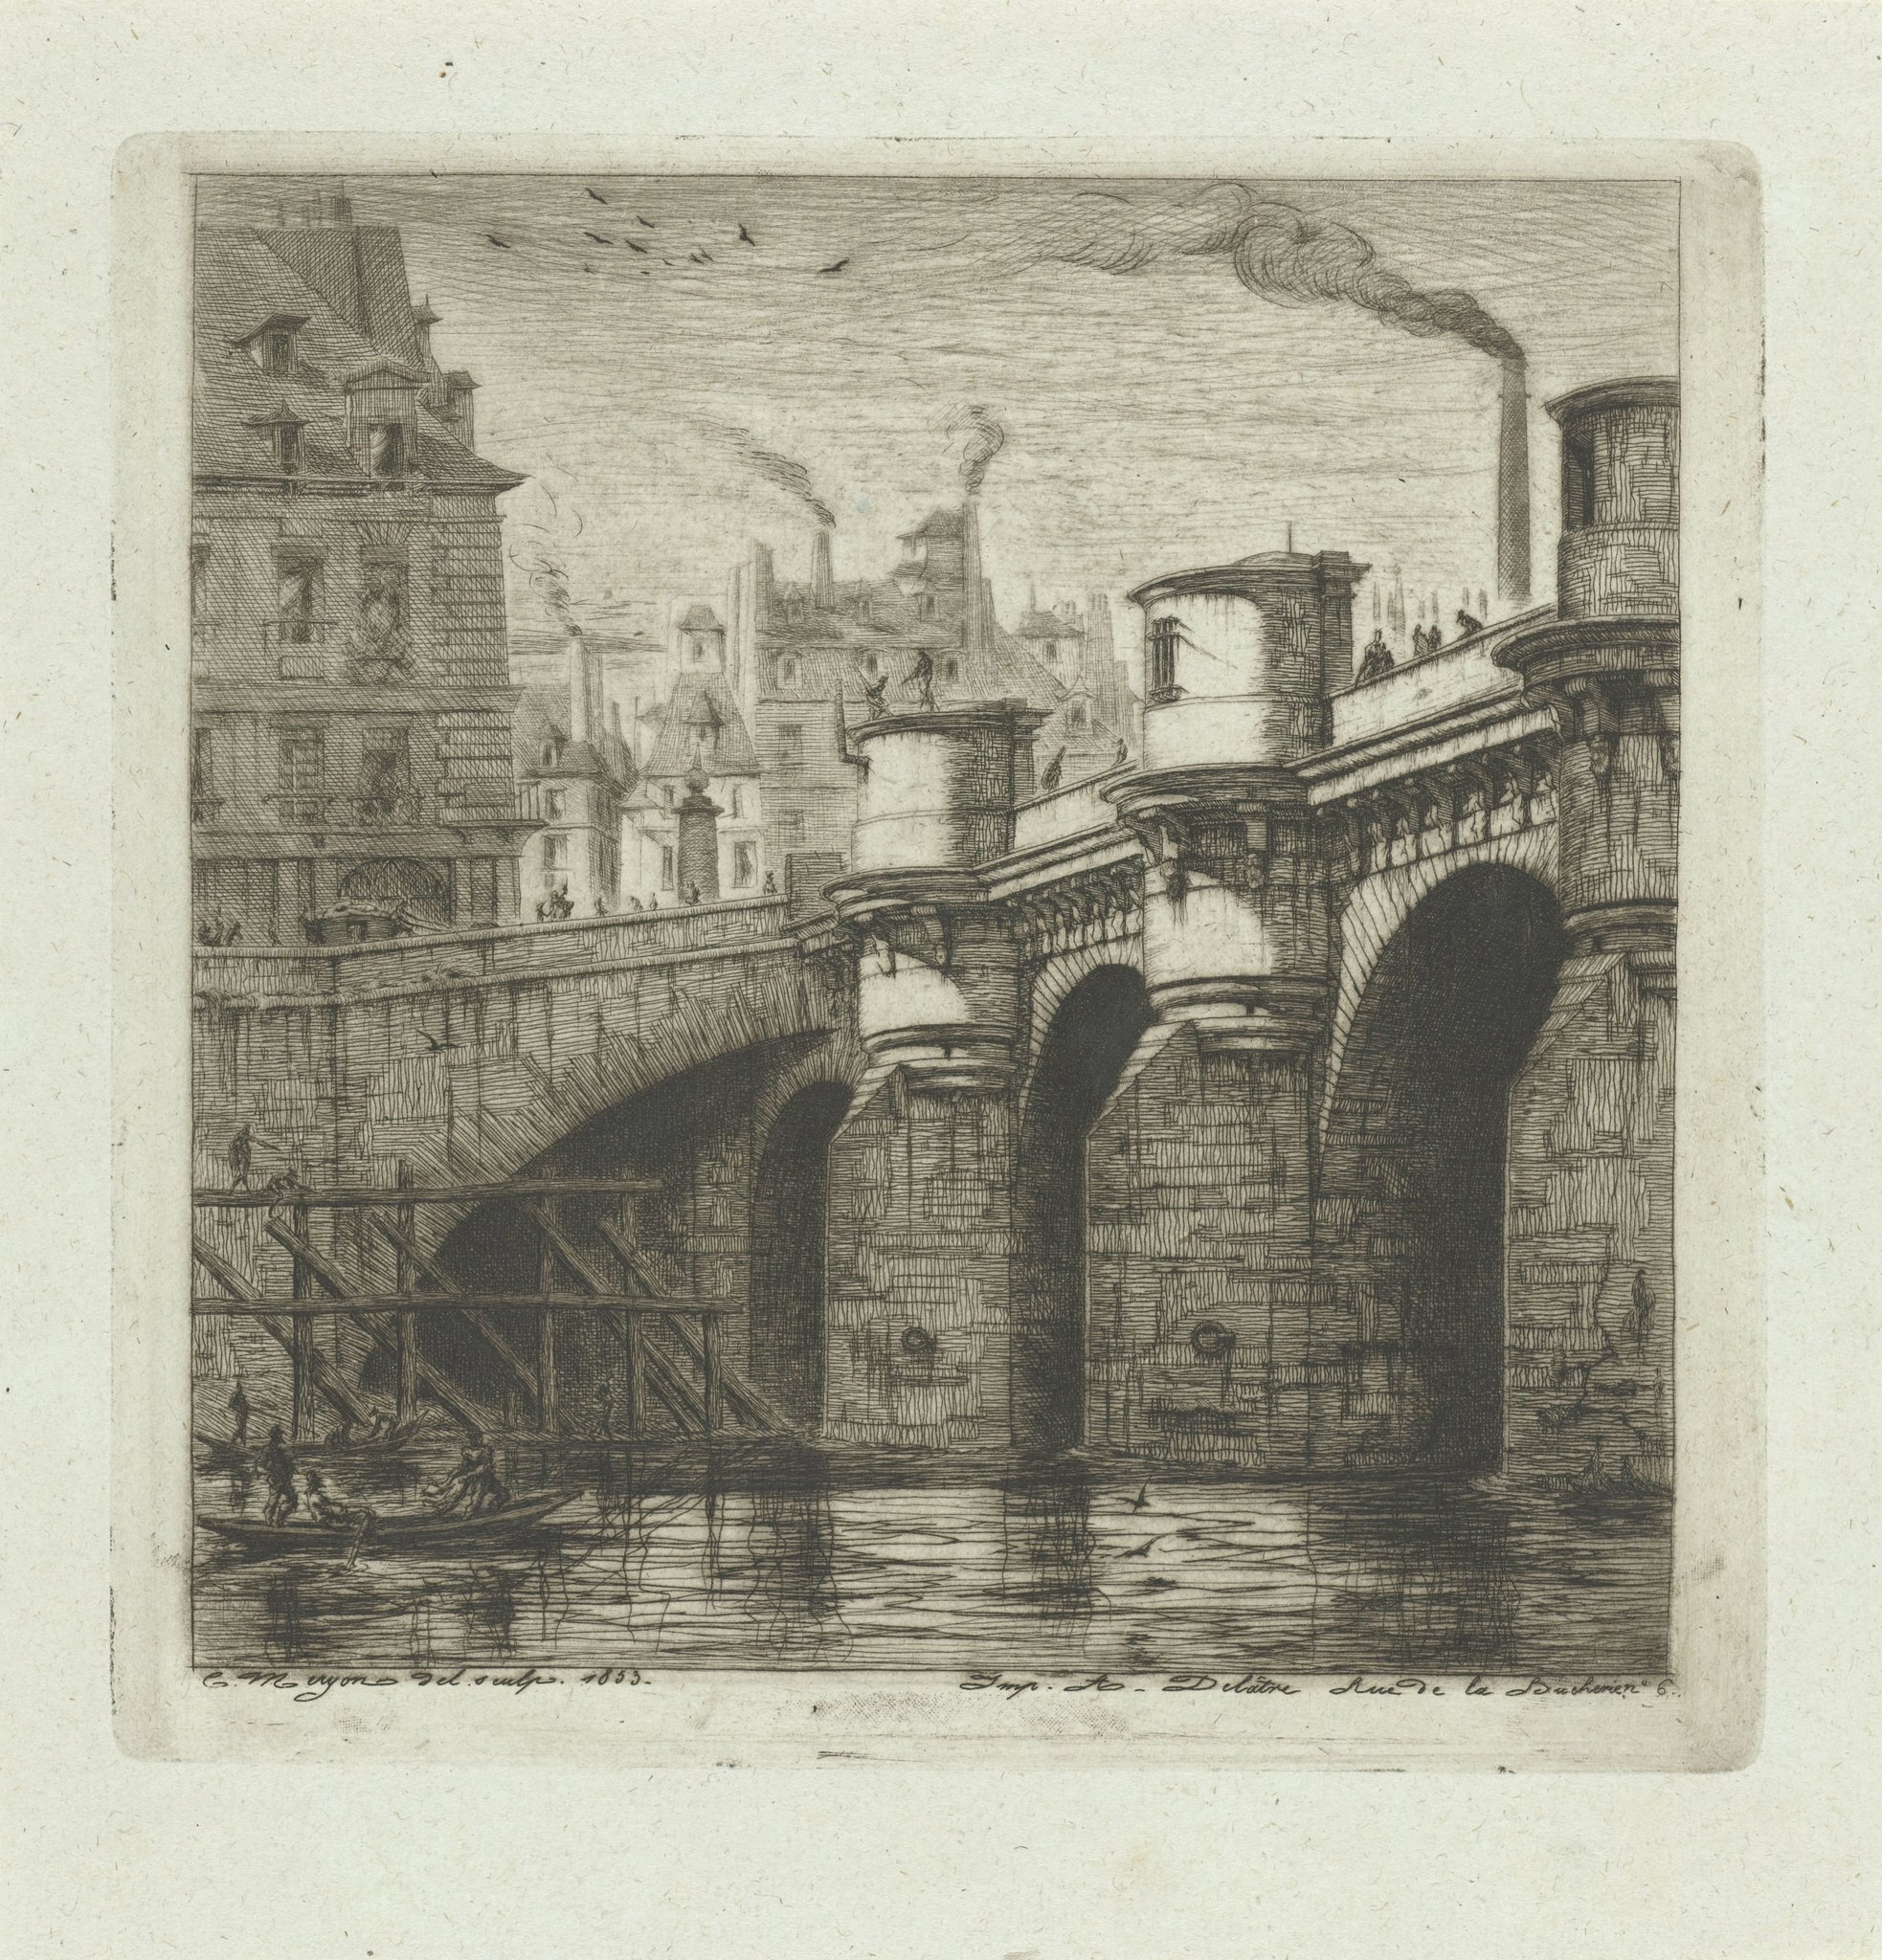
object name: print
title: Eaux-Fortes sur Paris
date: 1853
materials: paper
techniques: drypoint, etching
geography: paris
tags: bridge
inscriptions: collector's mark: Lugt 2228, collector's mark:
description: Afkomstig uit album met titel Eaux-Fortes par Meryon. Het album bevatte een titelblad en twaalf prenten op opzetvellen welke bij elkaar waren gebracht door het Ministère de l'intérieur te Parijs op voorspraak van Jules Niels. Vanwege de kwetsbaarheid van de prenten zijn deze uit het album gehaald en wordt de oude band met lege opzetvellen in de collectie van het RMA bewaard. Deze ets bevond zich op opzetvel p. 1. Meryon was van plan om een serie stadsgezichten van Parijs in een album uit te geven. De serie losse prenten staat bekend onder de titel Eaux-Fortes sur Paris. Waarschijnlijk heeft Meryon in enkele gevallen op verzoek series gedrukt zoals voor het Parijse ministerie (De Groot 1991, p. 23, 24).